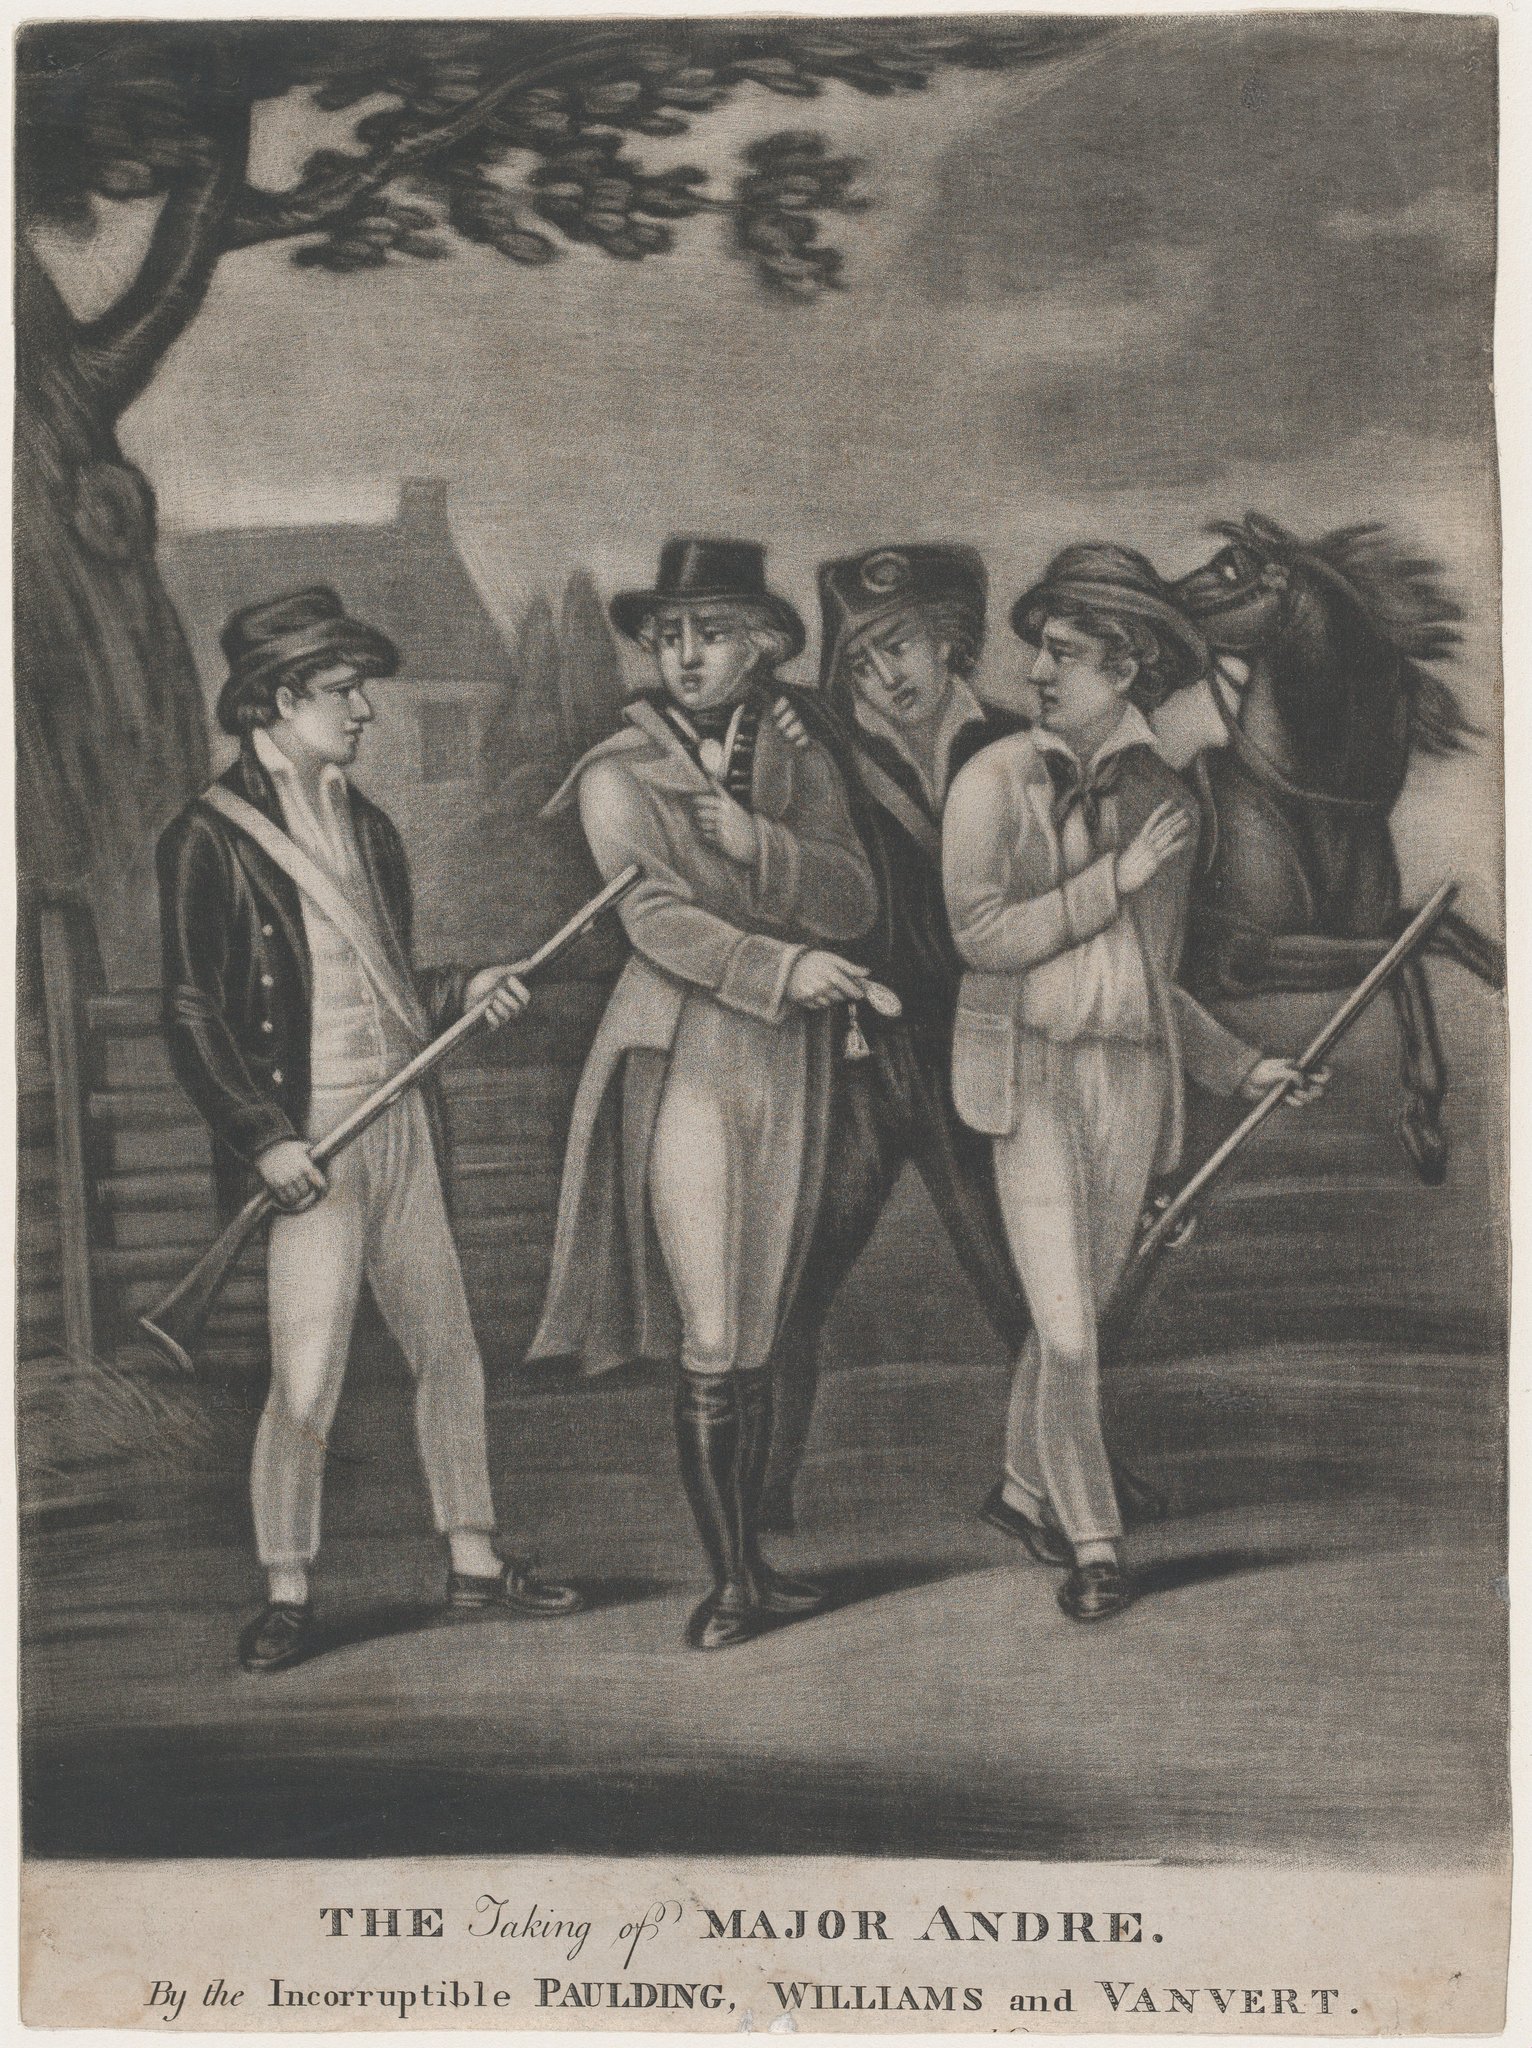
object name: print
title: The Taking of Major André by the Incorruptible Paulding, Williams and Vanvert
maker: t. w. freeman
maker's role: publisher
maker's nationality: american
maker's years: 1800-1820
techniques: mezzotint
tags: men,horses